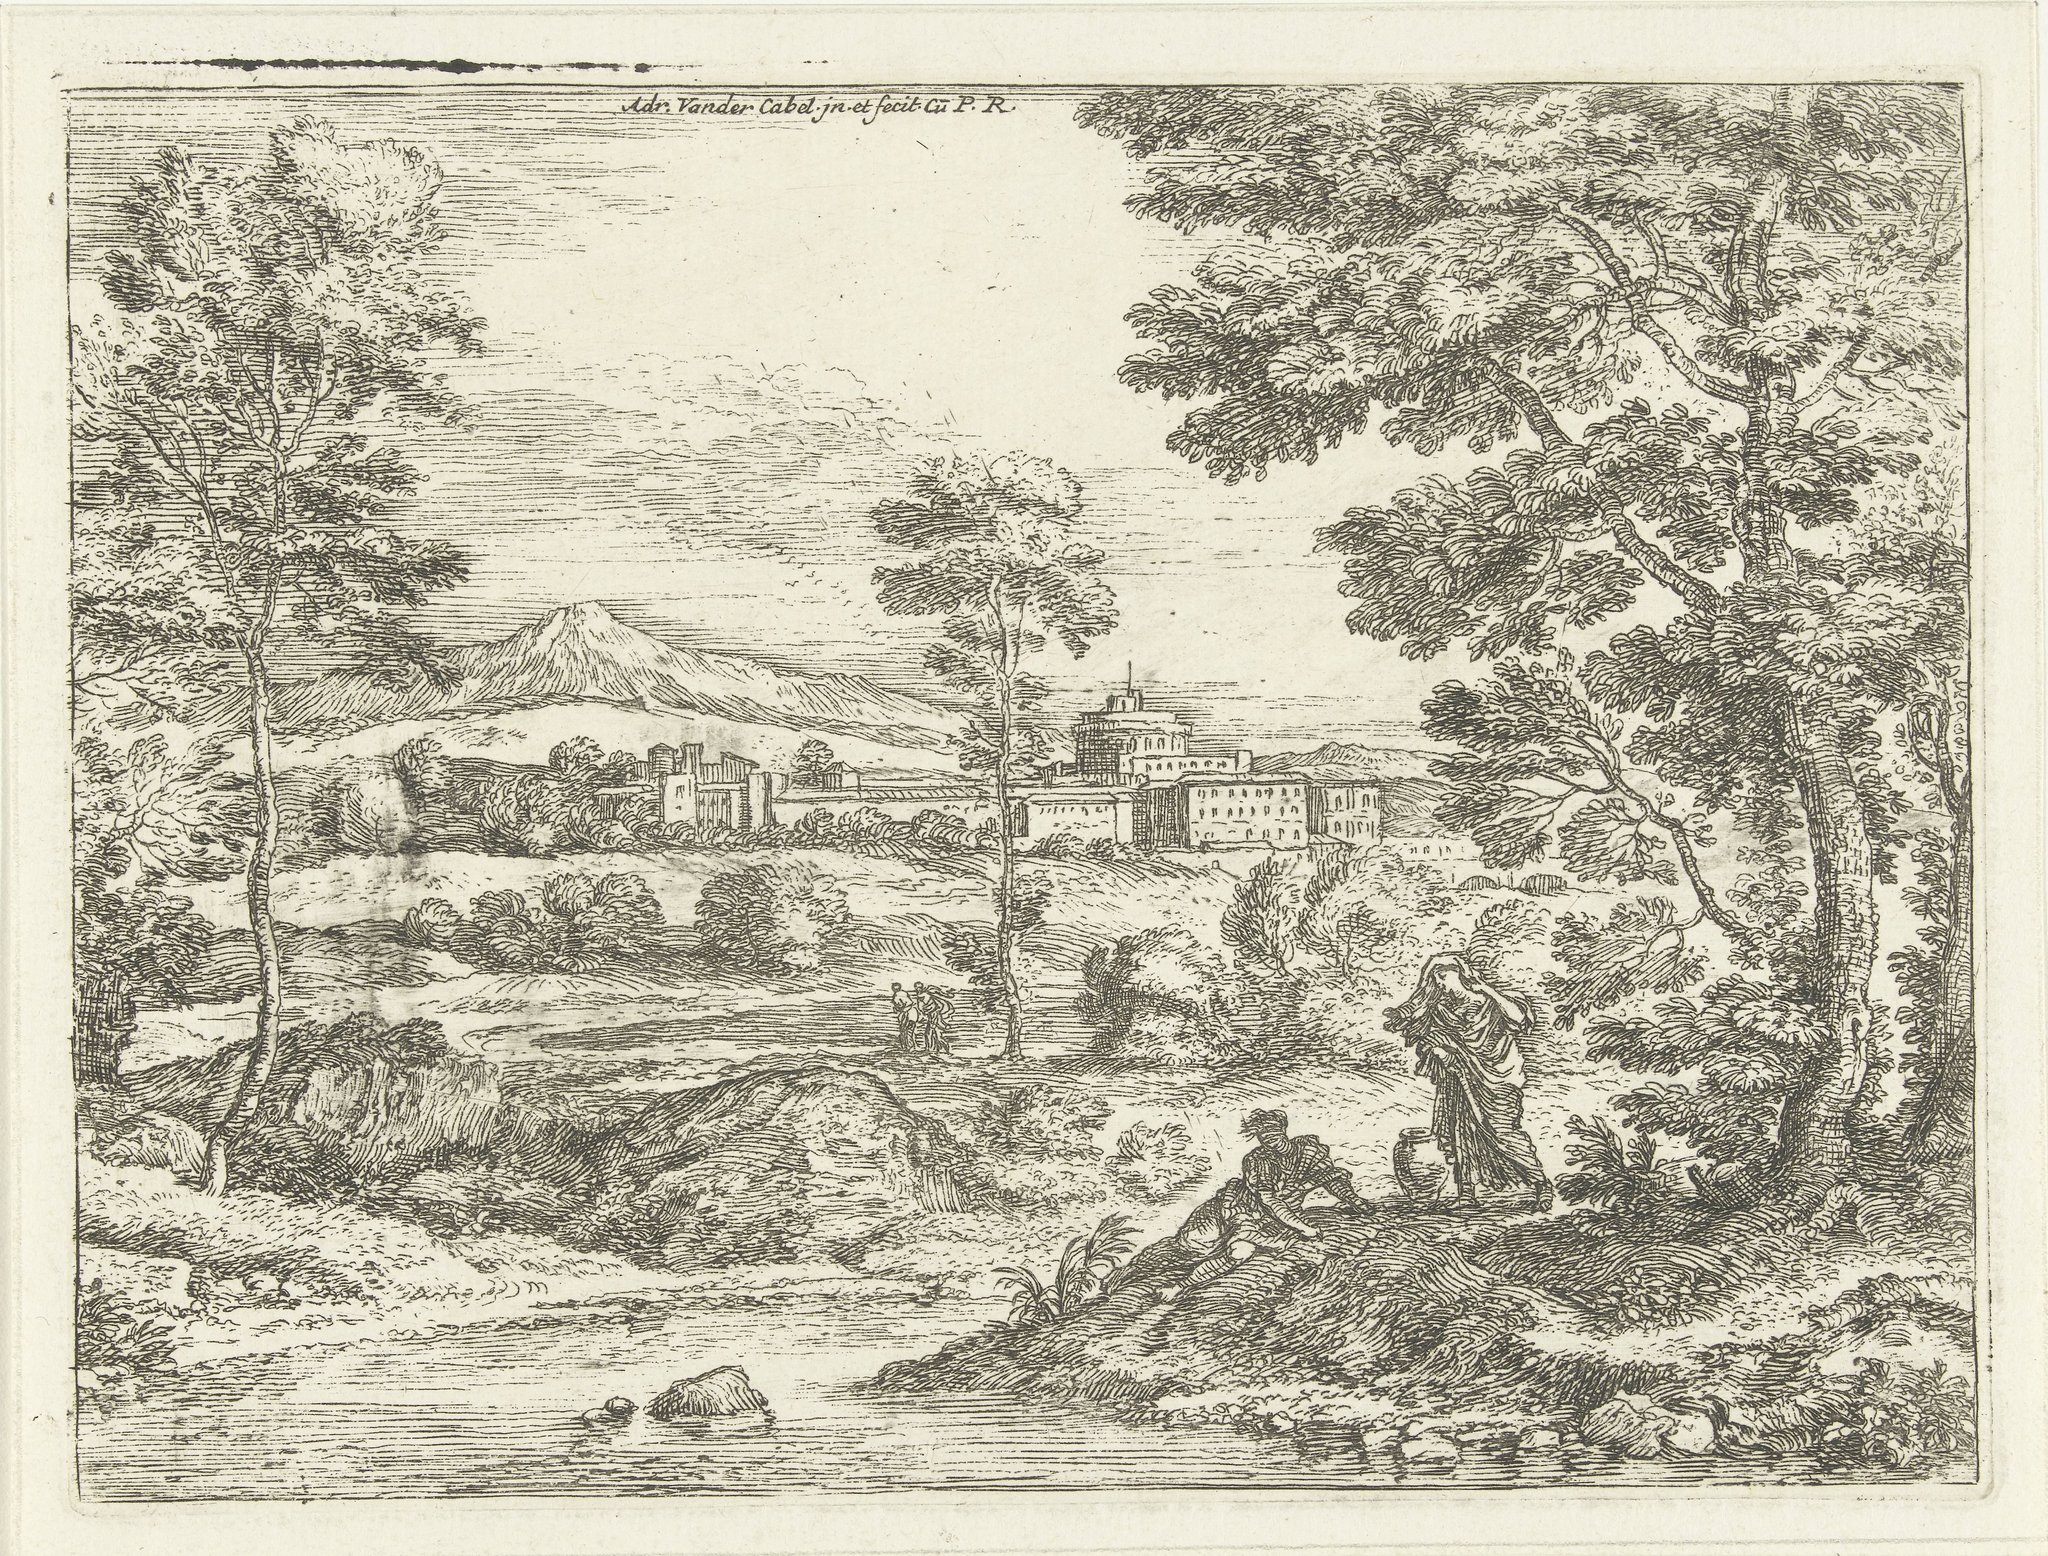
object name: print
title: Landschappen, serie twee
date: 1648-1705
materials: paper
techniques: etching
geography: france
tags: landscapes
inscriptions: collector's mark: Lugt 240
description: Landschap met gesluierde vrouw, staand bij pot, kijkend naar persoon liggend op de oever van een rivier. Een stad op de achtergrond. Zesde prent uit de serie van zes.